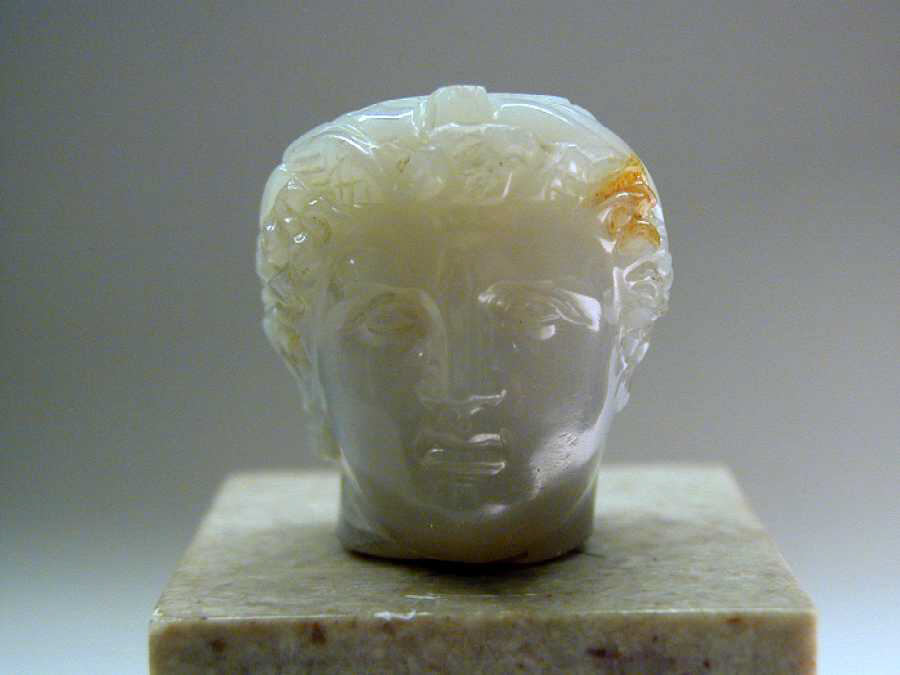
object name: head of hermes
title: Chalcedony winged head of Mercury (Hermes)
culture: roman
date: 1-200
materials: stone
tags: mercury